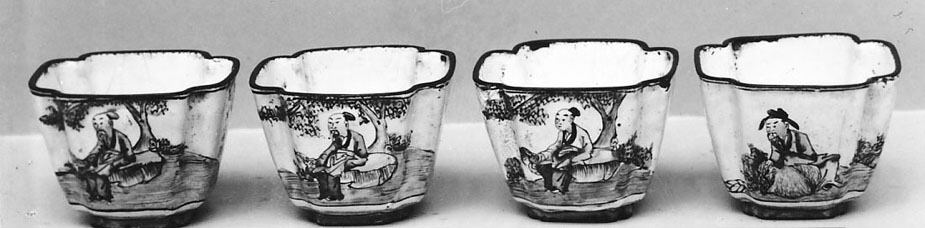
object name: cup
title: Square Cup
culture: chinese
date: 1736-1795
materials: enamel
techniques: painting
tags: men,trees